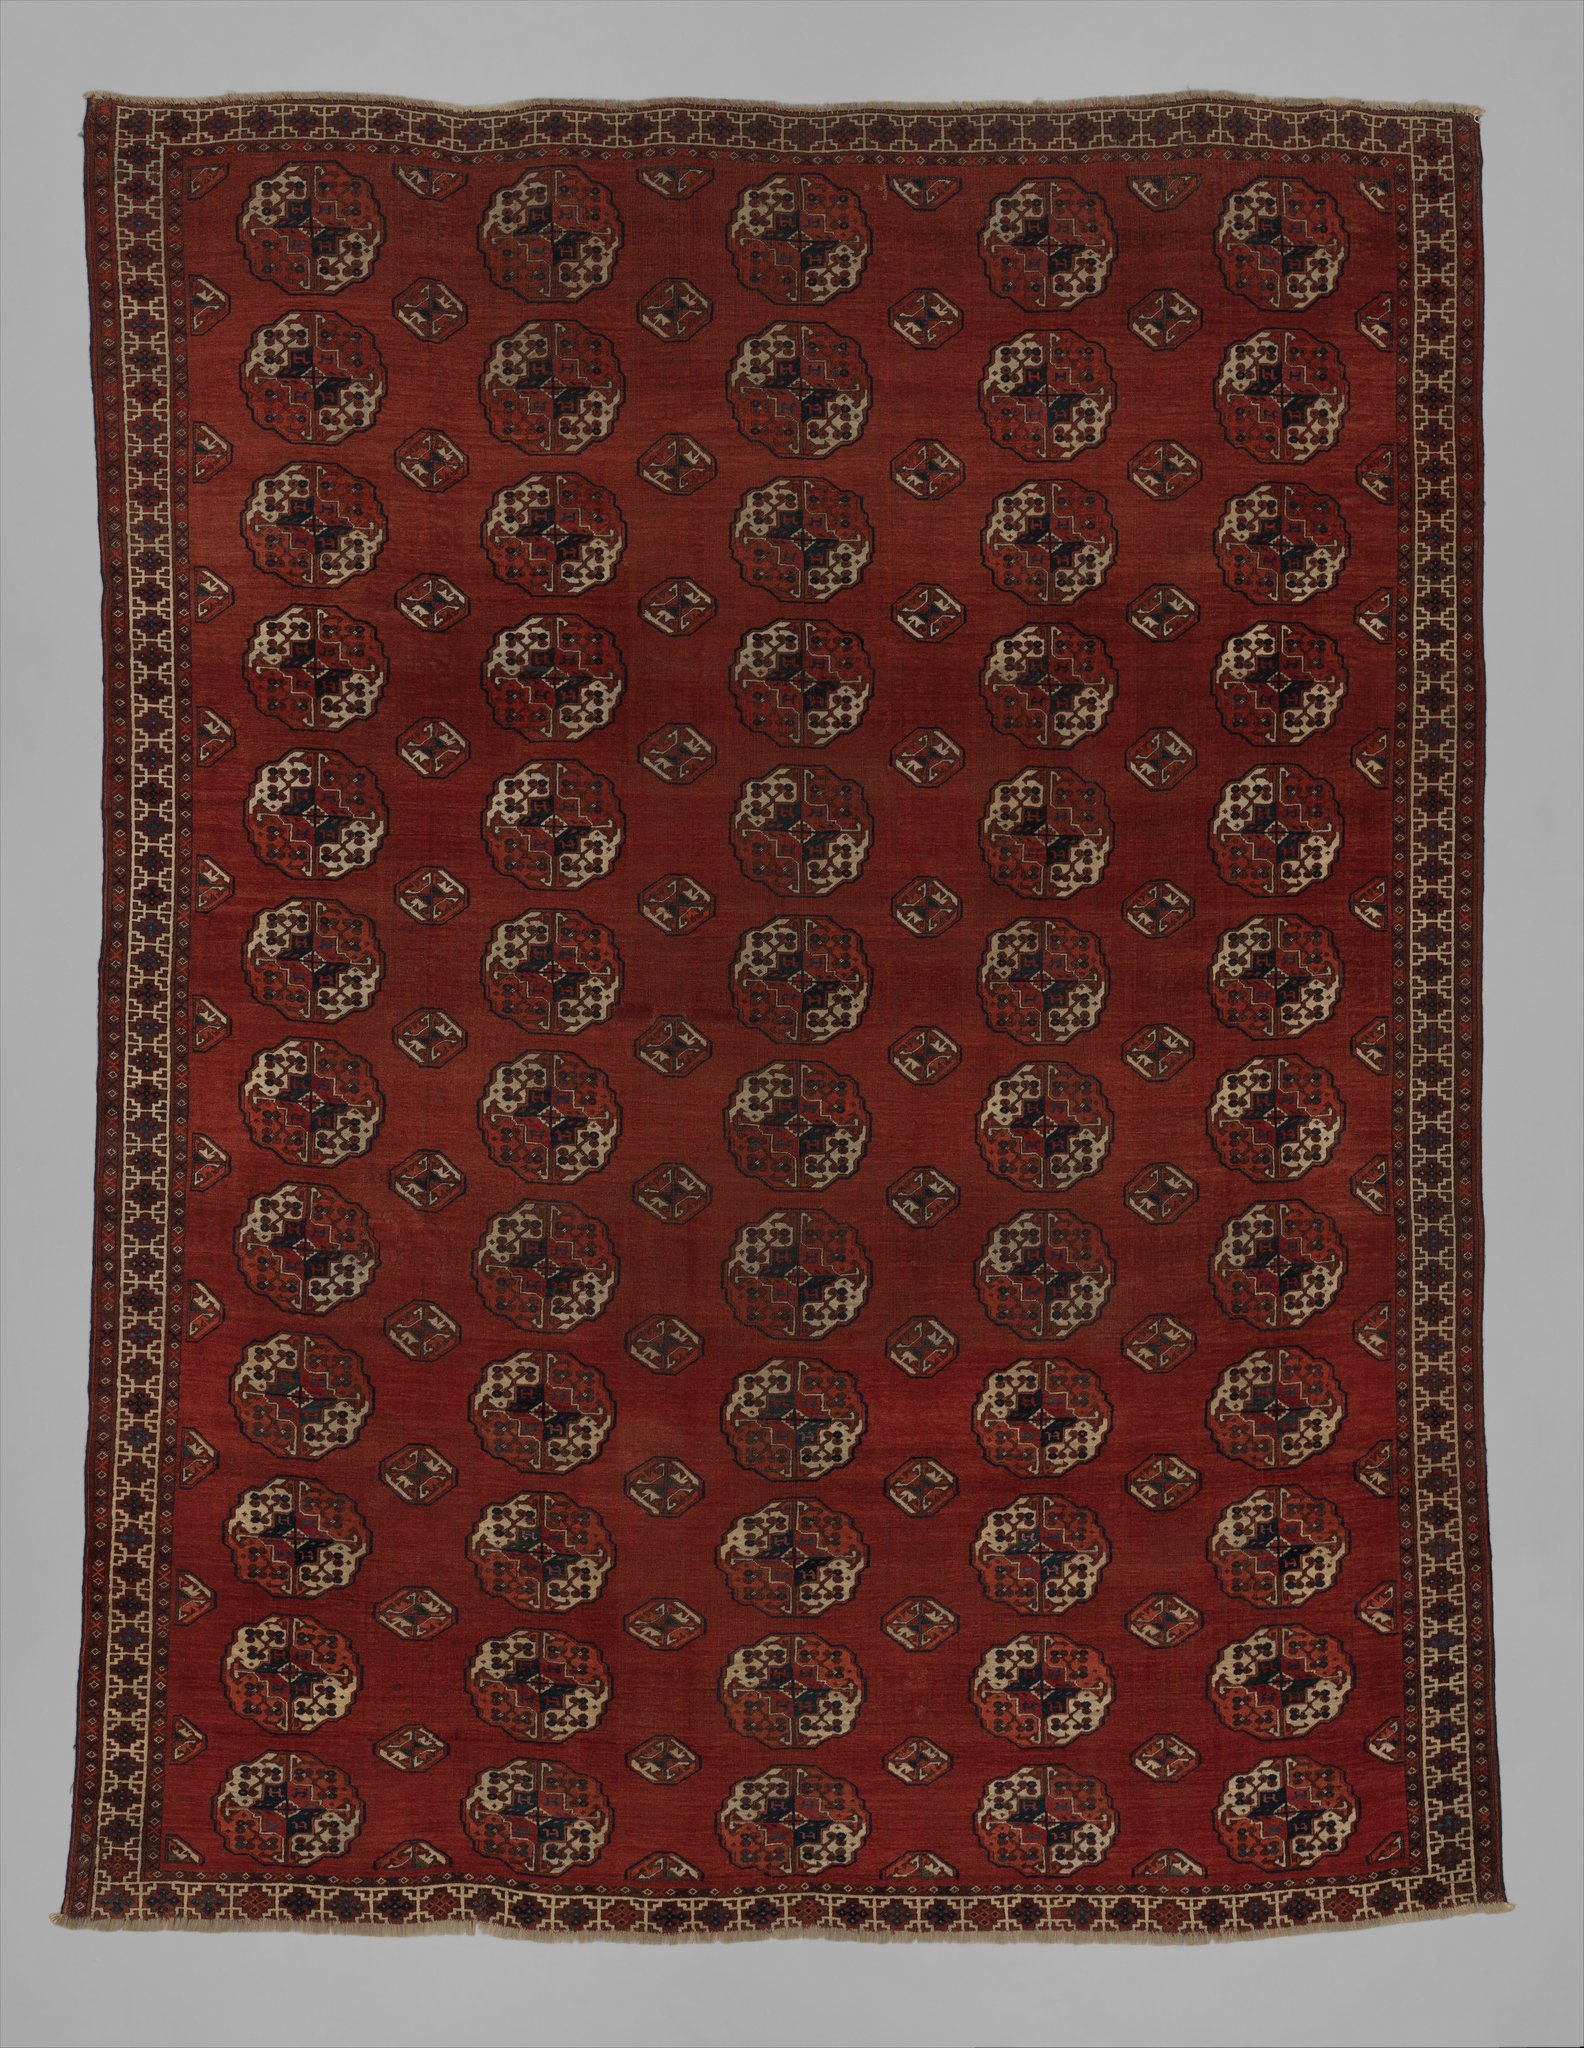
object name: carpet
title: Salor Main Carpet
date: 1767-1833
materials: silk, wool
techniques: asymmetrically knotted pile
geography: turkmenistan